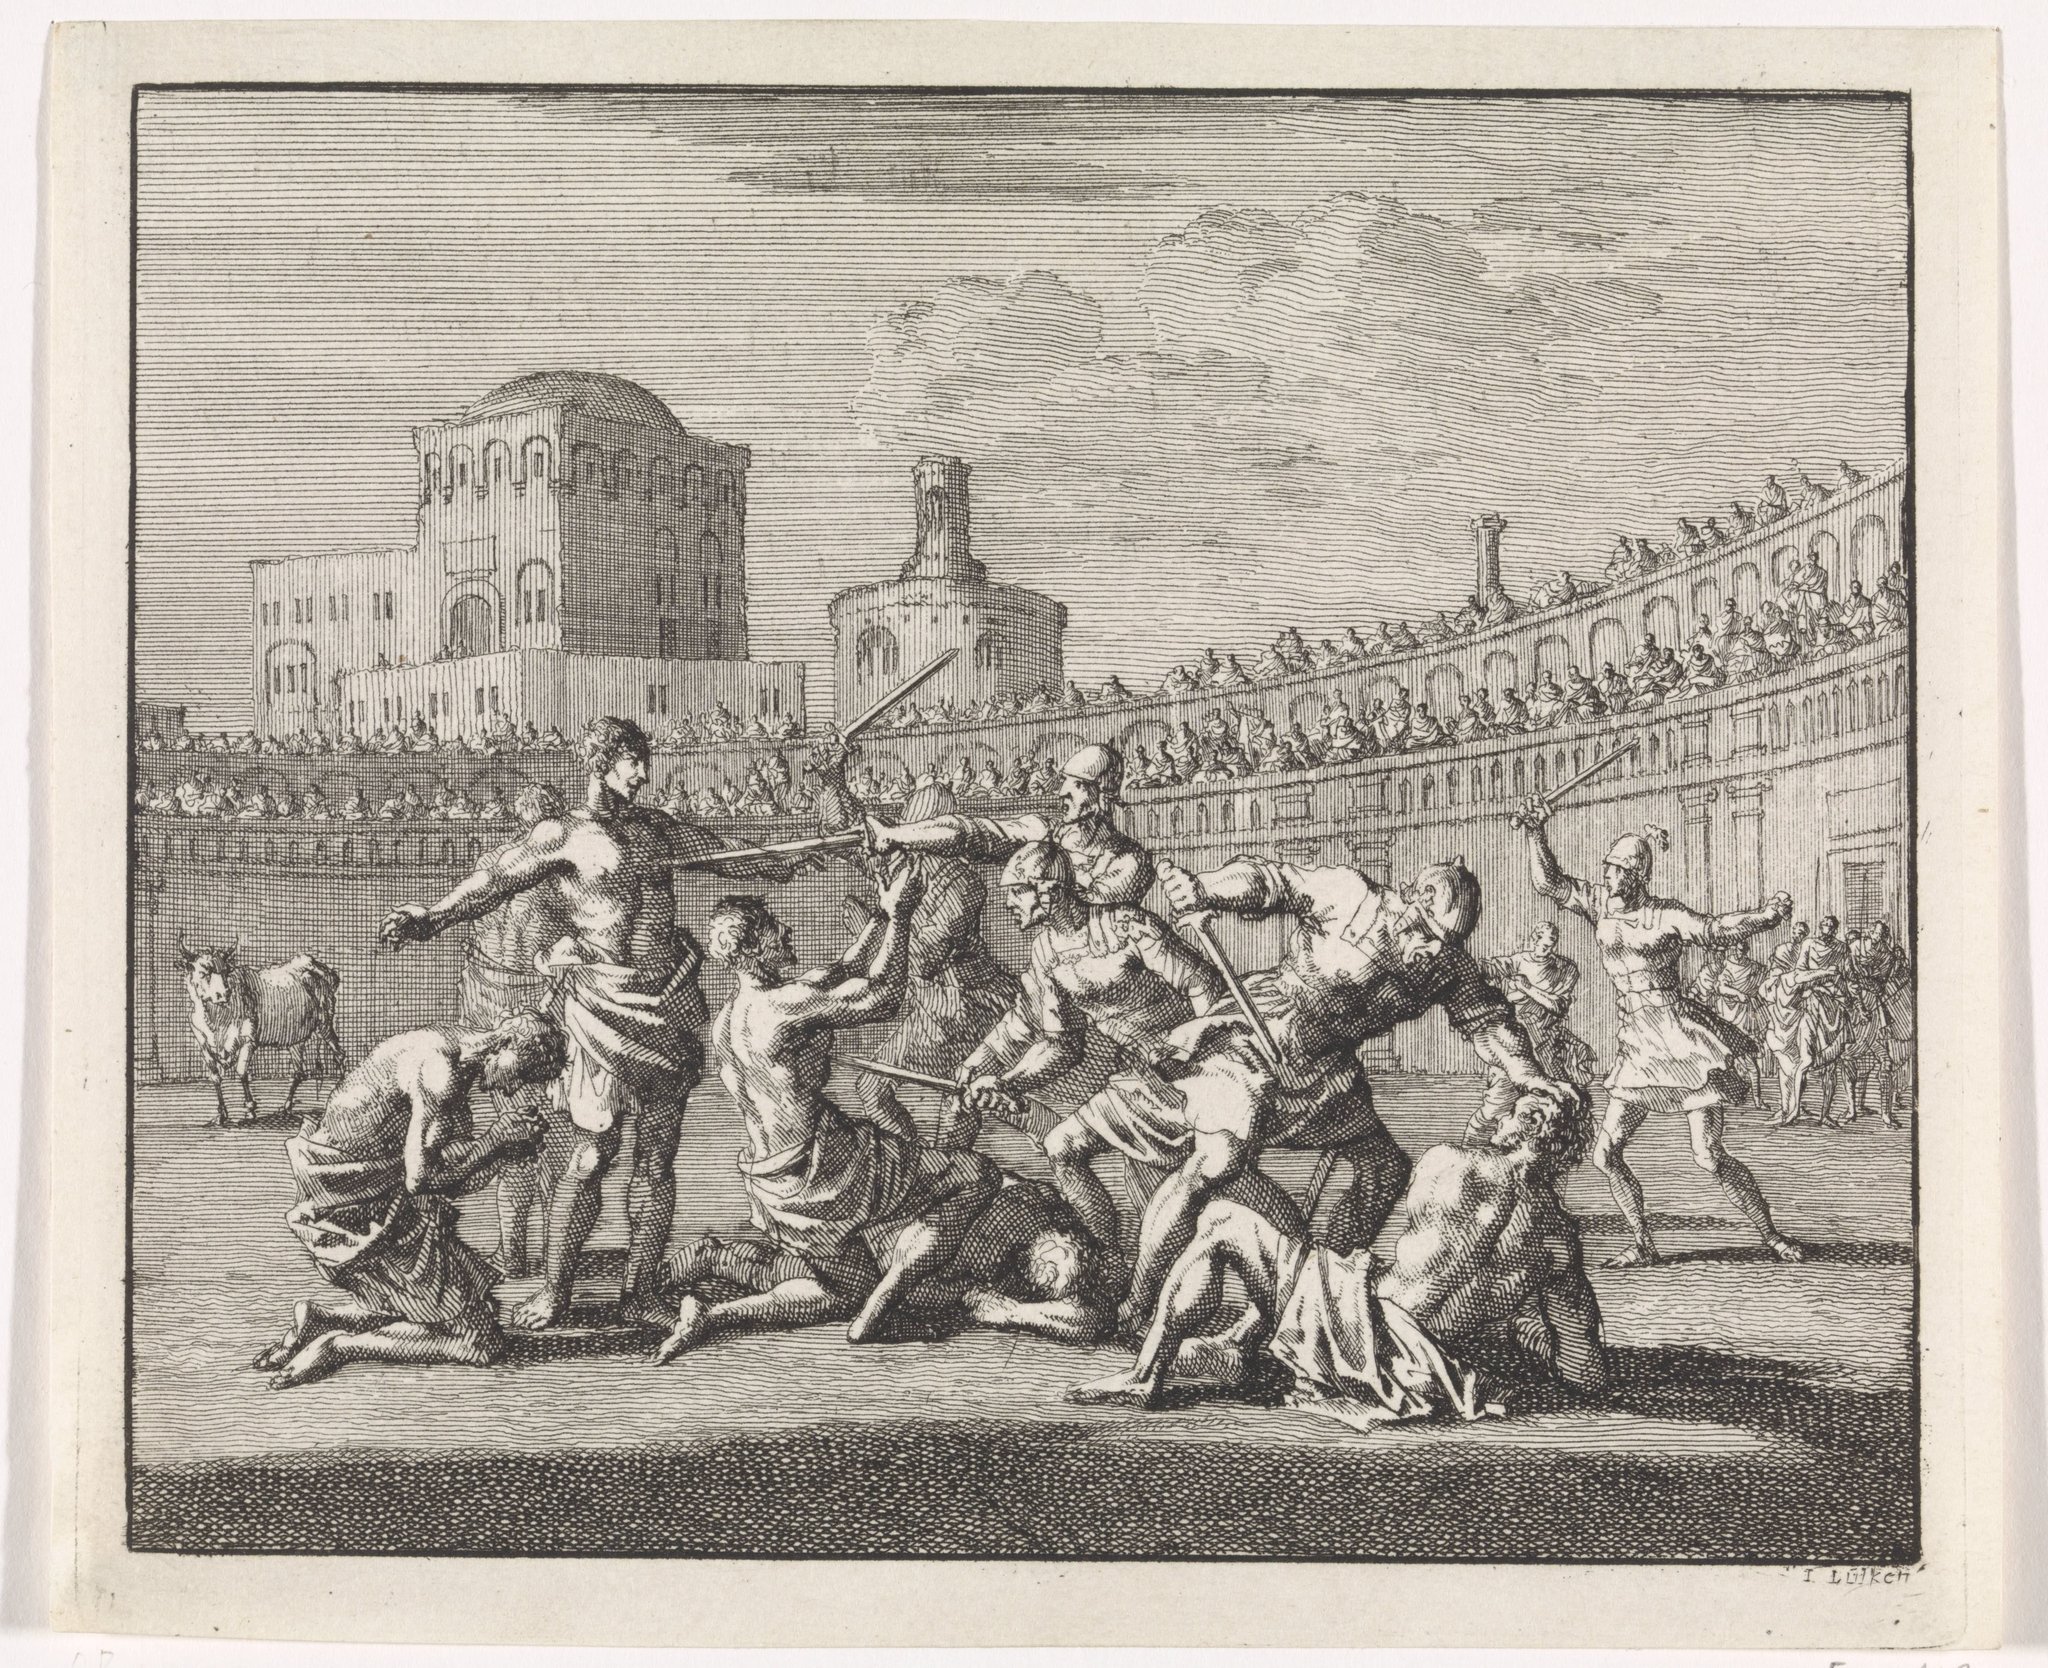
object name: print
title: Vroegchristelijke martelaren worden in een arena afgeslacht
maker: jan luyken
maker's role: draughtsman, print maker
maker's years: 1649-1712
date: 1701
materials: paper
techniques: etching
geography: amsterdam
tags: violent death by cleaving and striking weapons, the early christian churches, e.g. armenians, copts, syrians, martyr(s) (often with palm-branches)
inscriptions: collector's mark: Lugt 2228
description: Proefdruk van een boekillustratie Arnold, Godfried. Waare afbeelding der eerste christenen. Amsterdam: Jacobus van Hardenberg, Barent Visscher en Jacobus van Nieuweveen, 1700, dl. 2